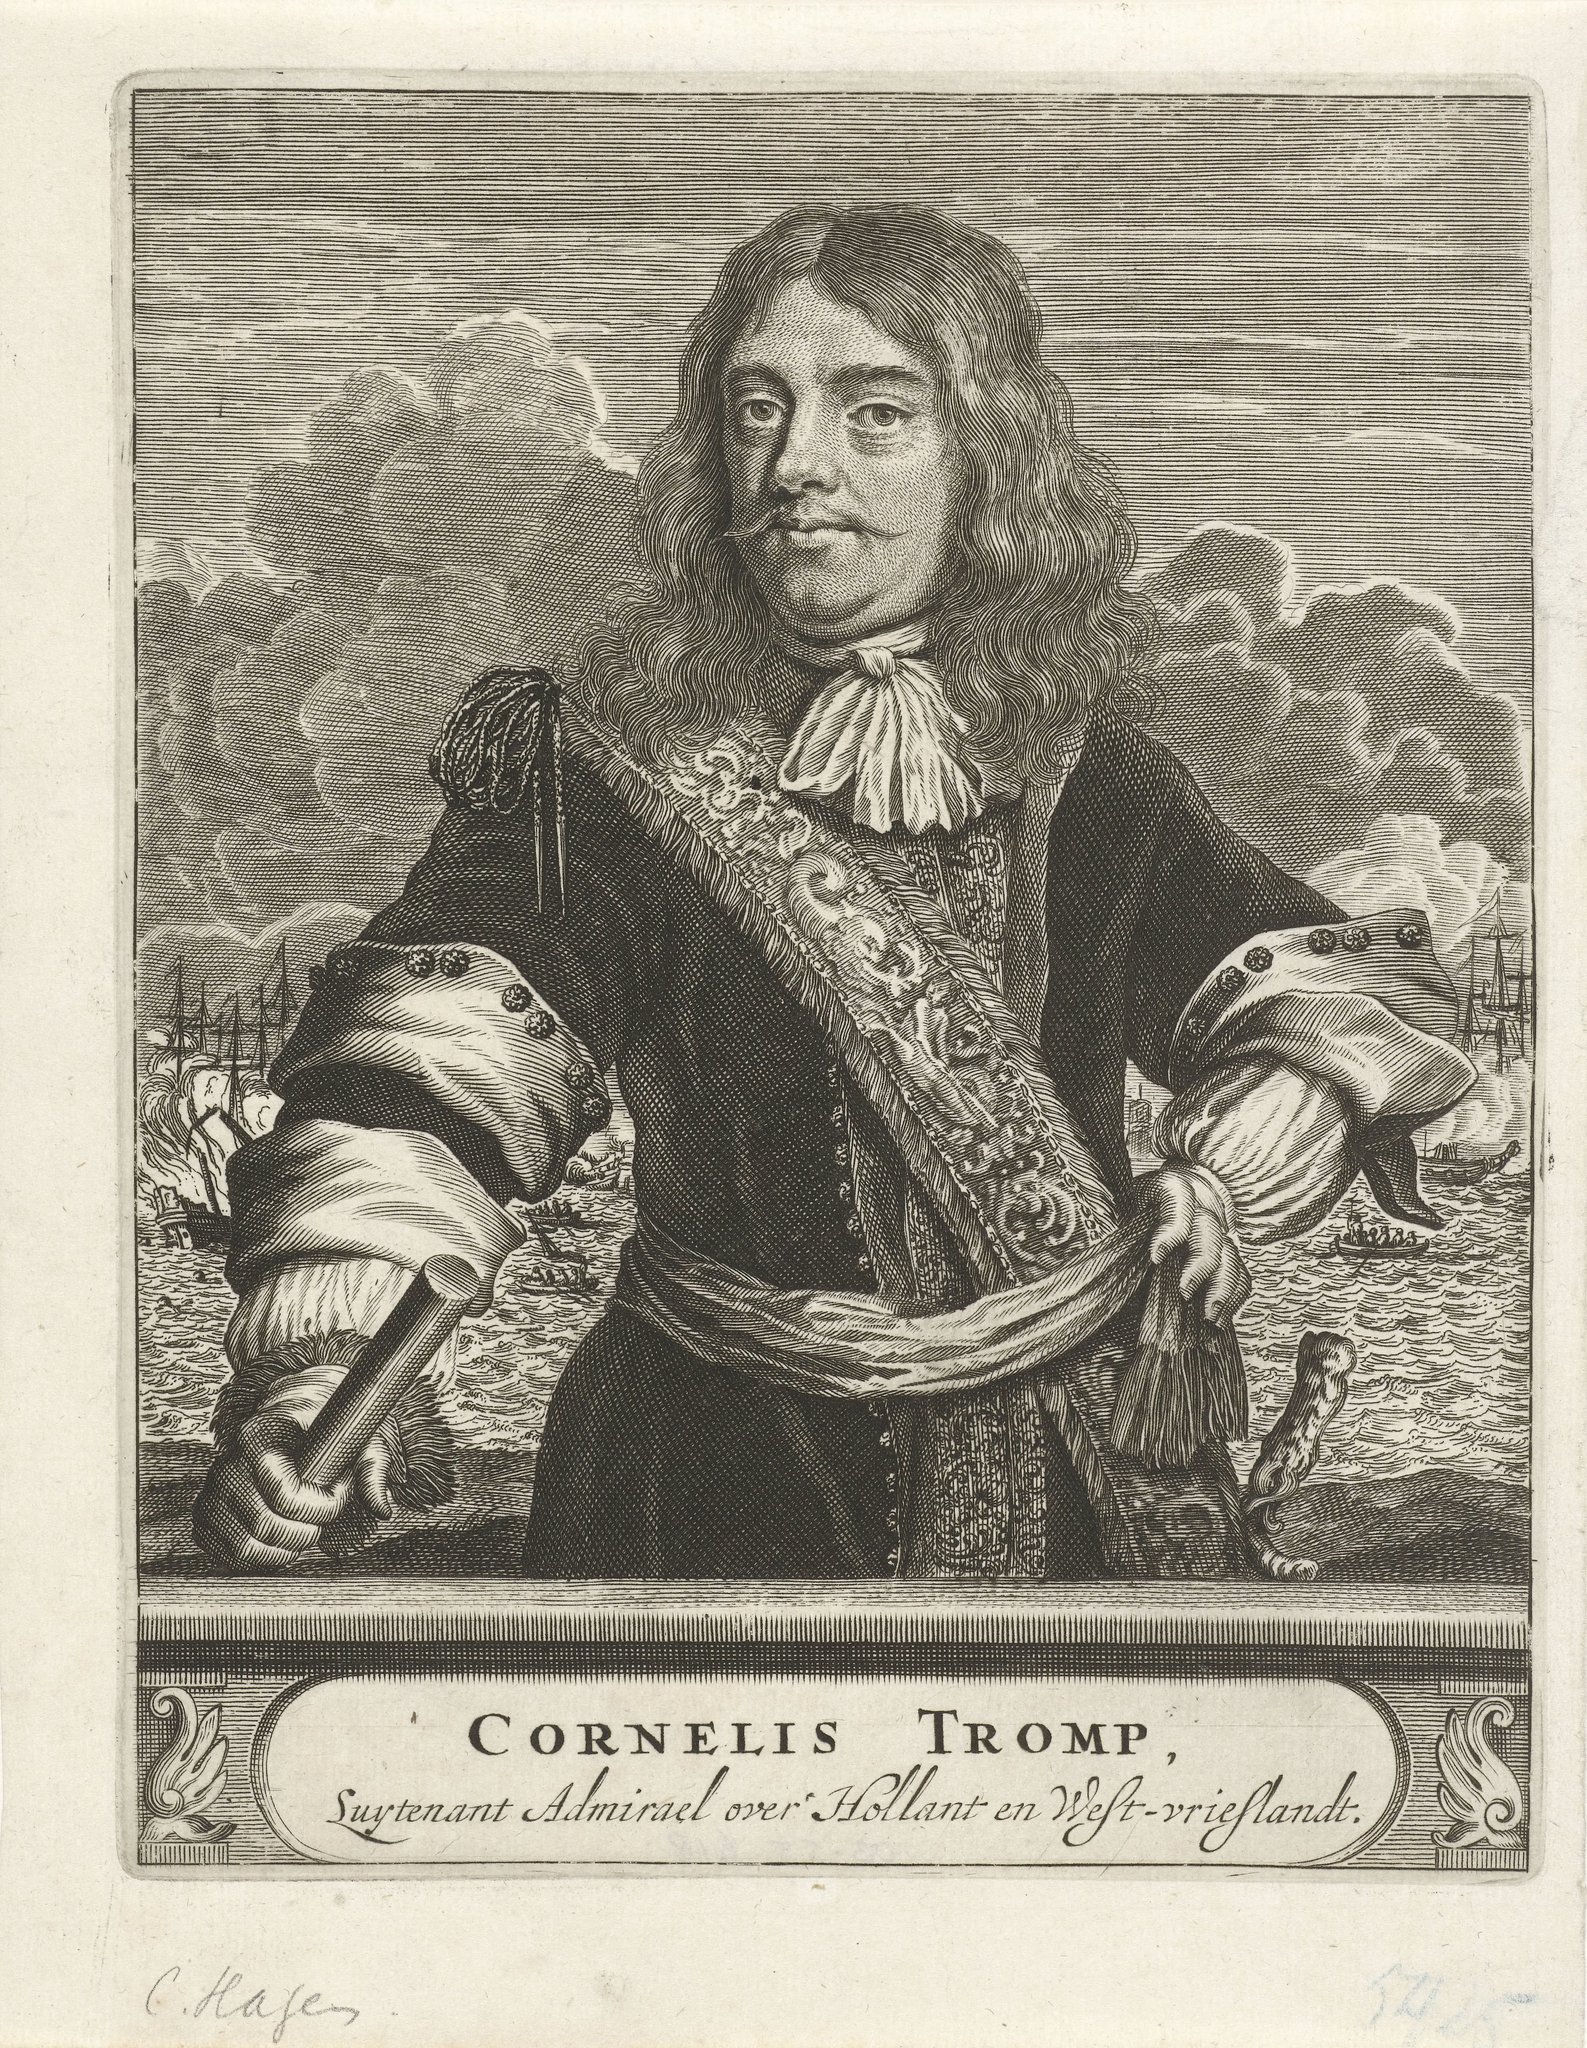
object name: print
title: Portret van Cornelis Tromp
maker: christiaan hagen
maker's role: draughtsman, print maker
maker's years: 1635-1707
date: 1663-1695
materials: paper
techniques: engraving, etching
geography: amsterdam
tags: moustache, shoulder-belt, bandoleer, battle, fighting in general (+ sailing-ships)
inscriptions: collector's mark: Lugt 2228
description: Portret ten halven lijve van Cornelis Tromp. In zijn rechterhand houdt hij een commandostaf. Op de achtergrond is een zeeslag afgebeeld. Onder zijn portret een plint, waarop zijn naam en titel in twee regels in een cartouche.